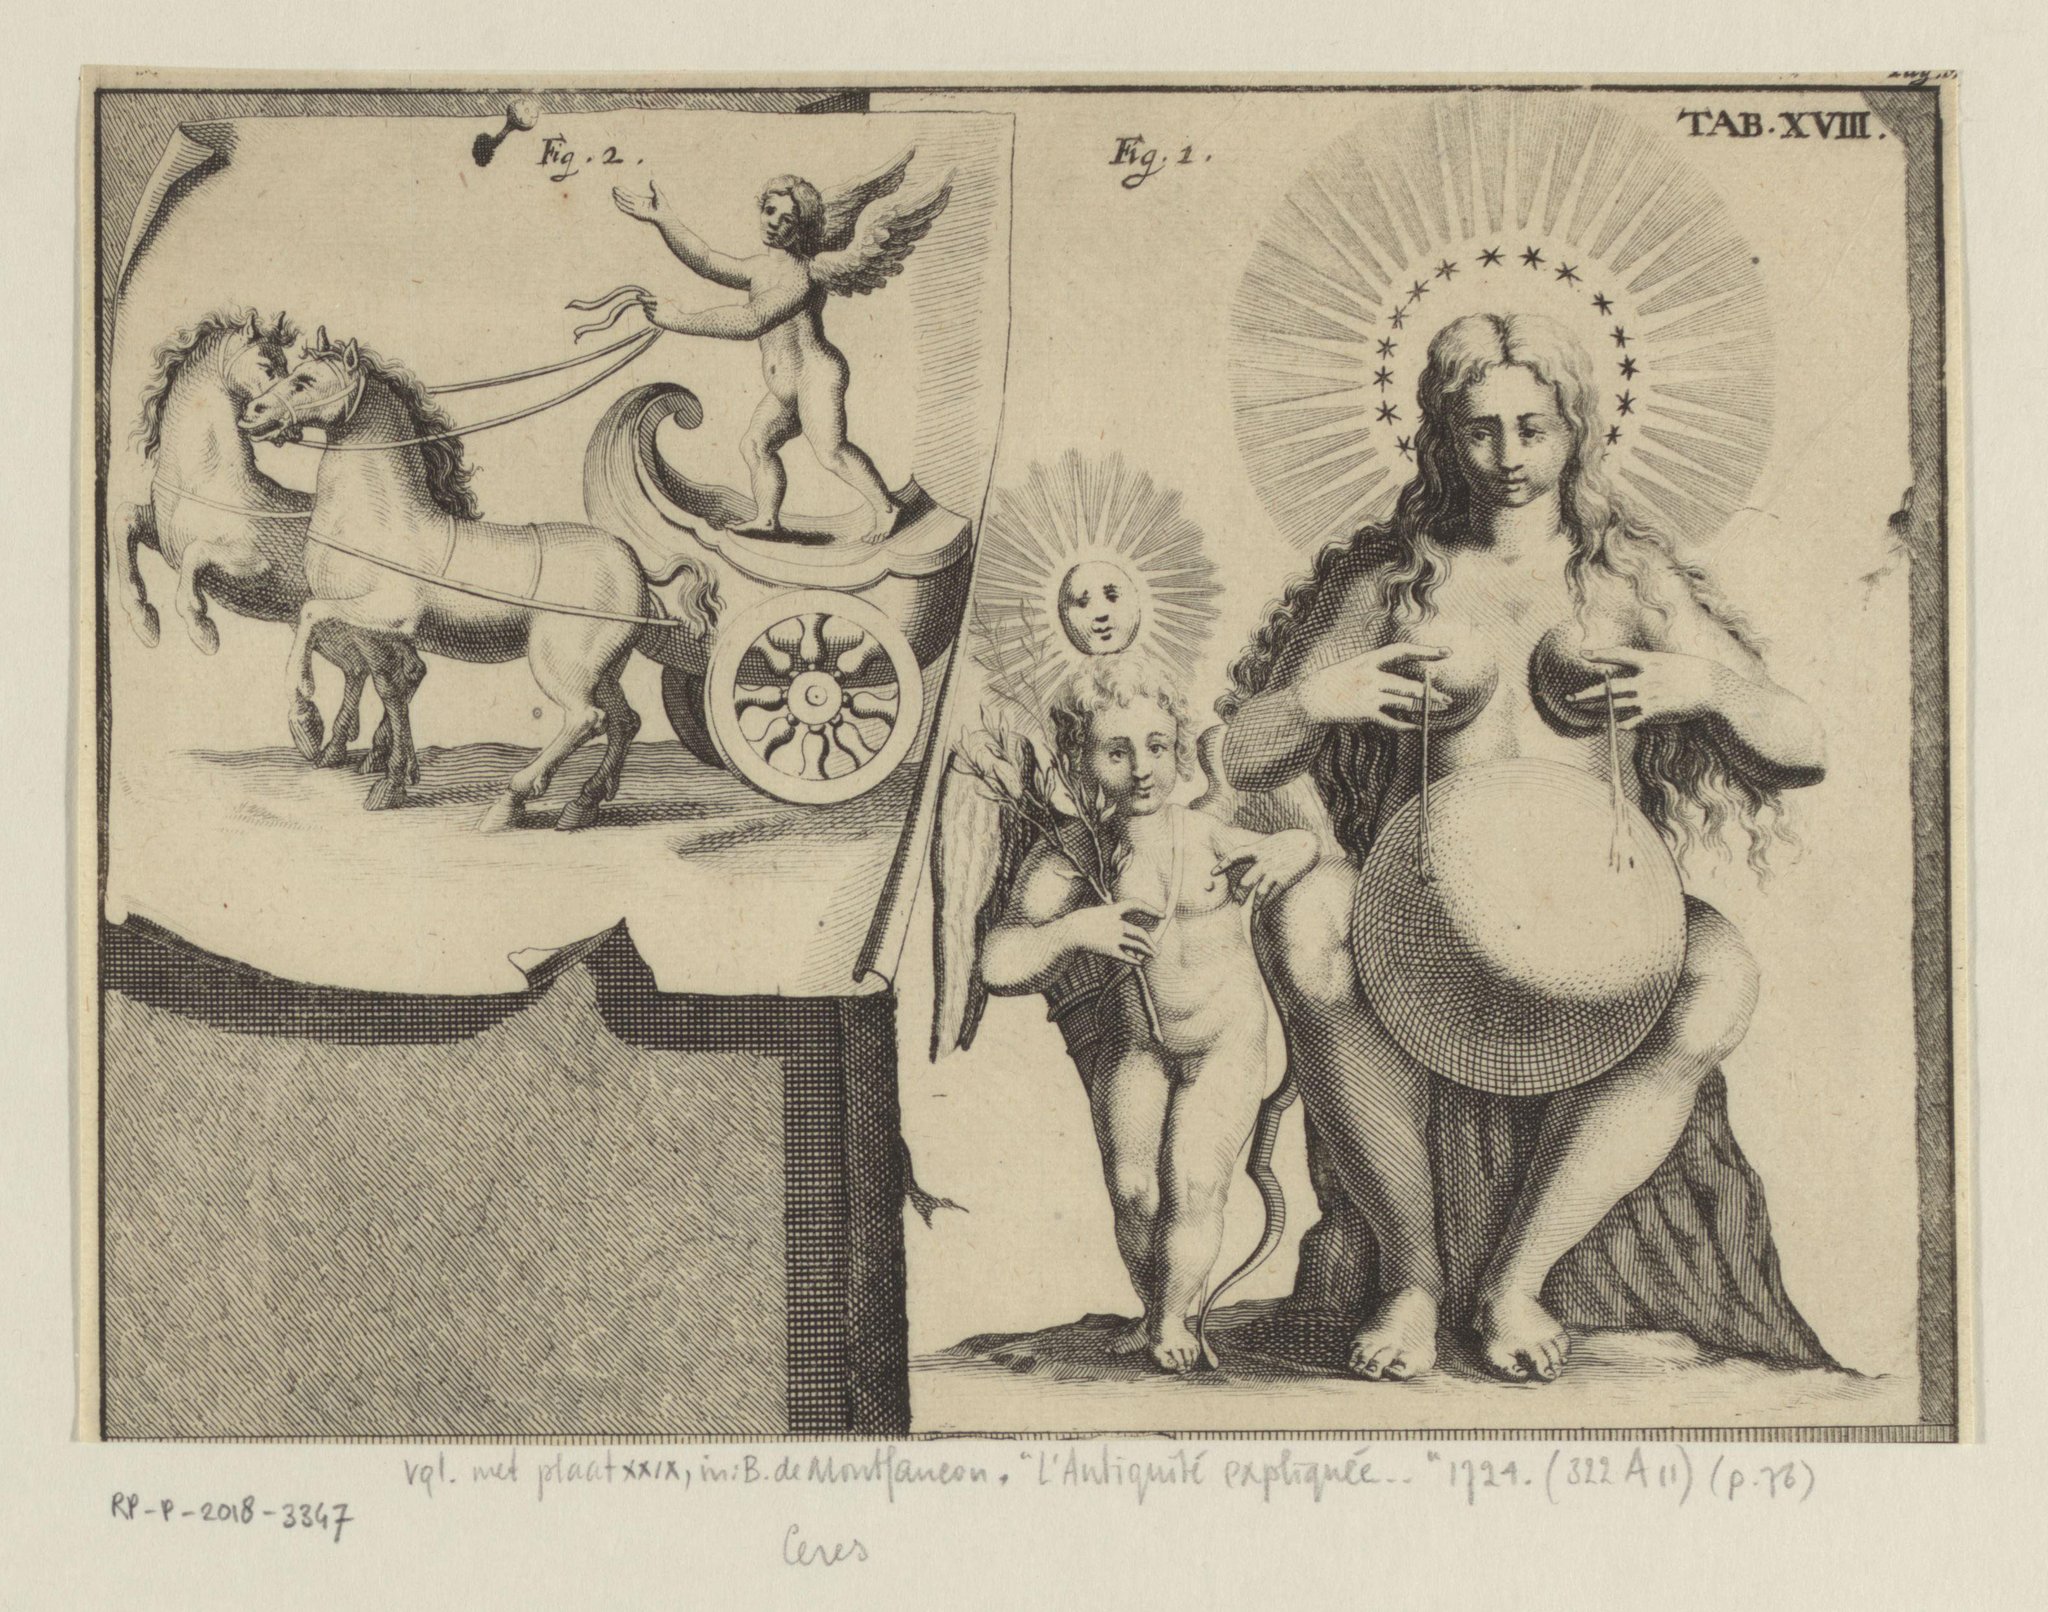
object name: print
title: Compositie met een tekening met een putto op een kar en een reliëf met een lacterende vrouw, mogelijk Ceres of Venus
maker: Anonymous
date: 1700-1799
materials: paper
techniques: engraving, etching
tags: (story of) ceres (demeter), drawing, sculpture (+ relief ~ sculpture)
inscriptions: collector's mark: Lugt 2228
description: Prent uit een onbekend boek met objecten, kunstwerken en figuren uit de Romeinse geschiedenis en religie. Het motief van de lacterende vrouw komt terug op p. 76 uit een boek door Bernard de Montfaucon uit 1724, getiteld 'l'Antiquité expliquée (...)'.